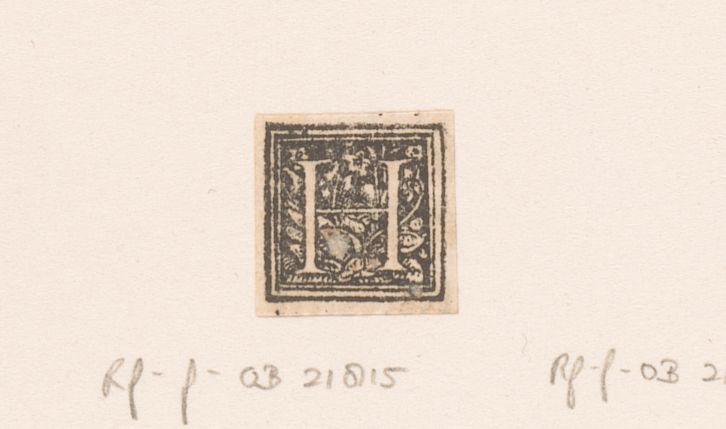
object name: print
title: Letter H: plant met bloemen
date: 1556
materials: paper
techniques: letterpress printing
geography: zurich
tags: initial, ornament derived from plant forms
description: Prent afkomstig uit: Bibel, die gantze, das ist alle Bücher alts und news Testaments (...). Zürich: Johann Froschauer, 1556.